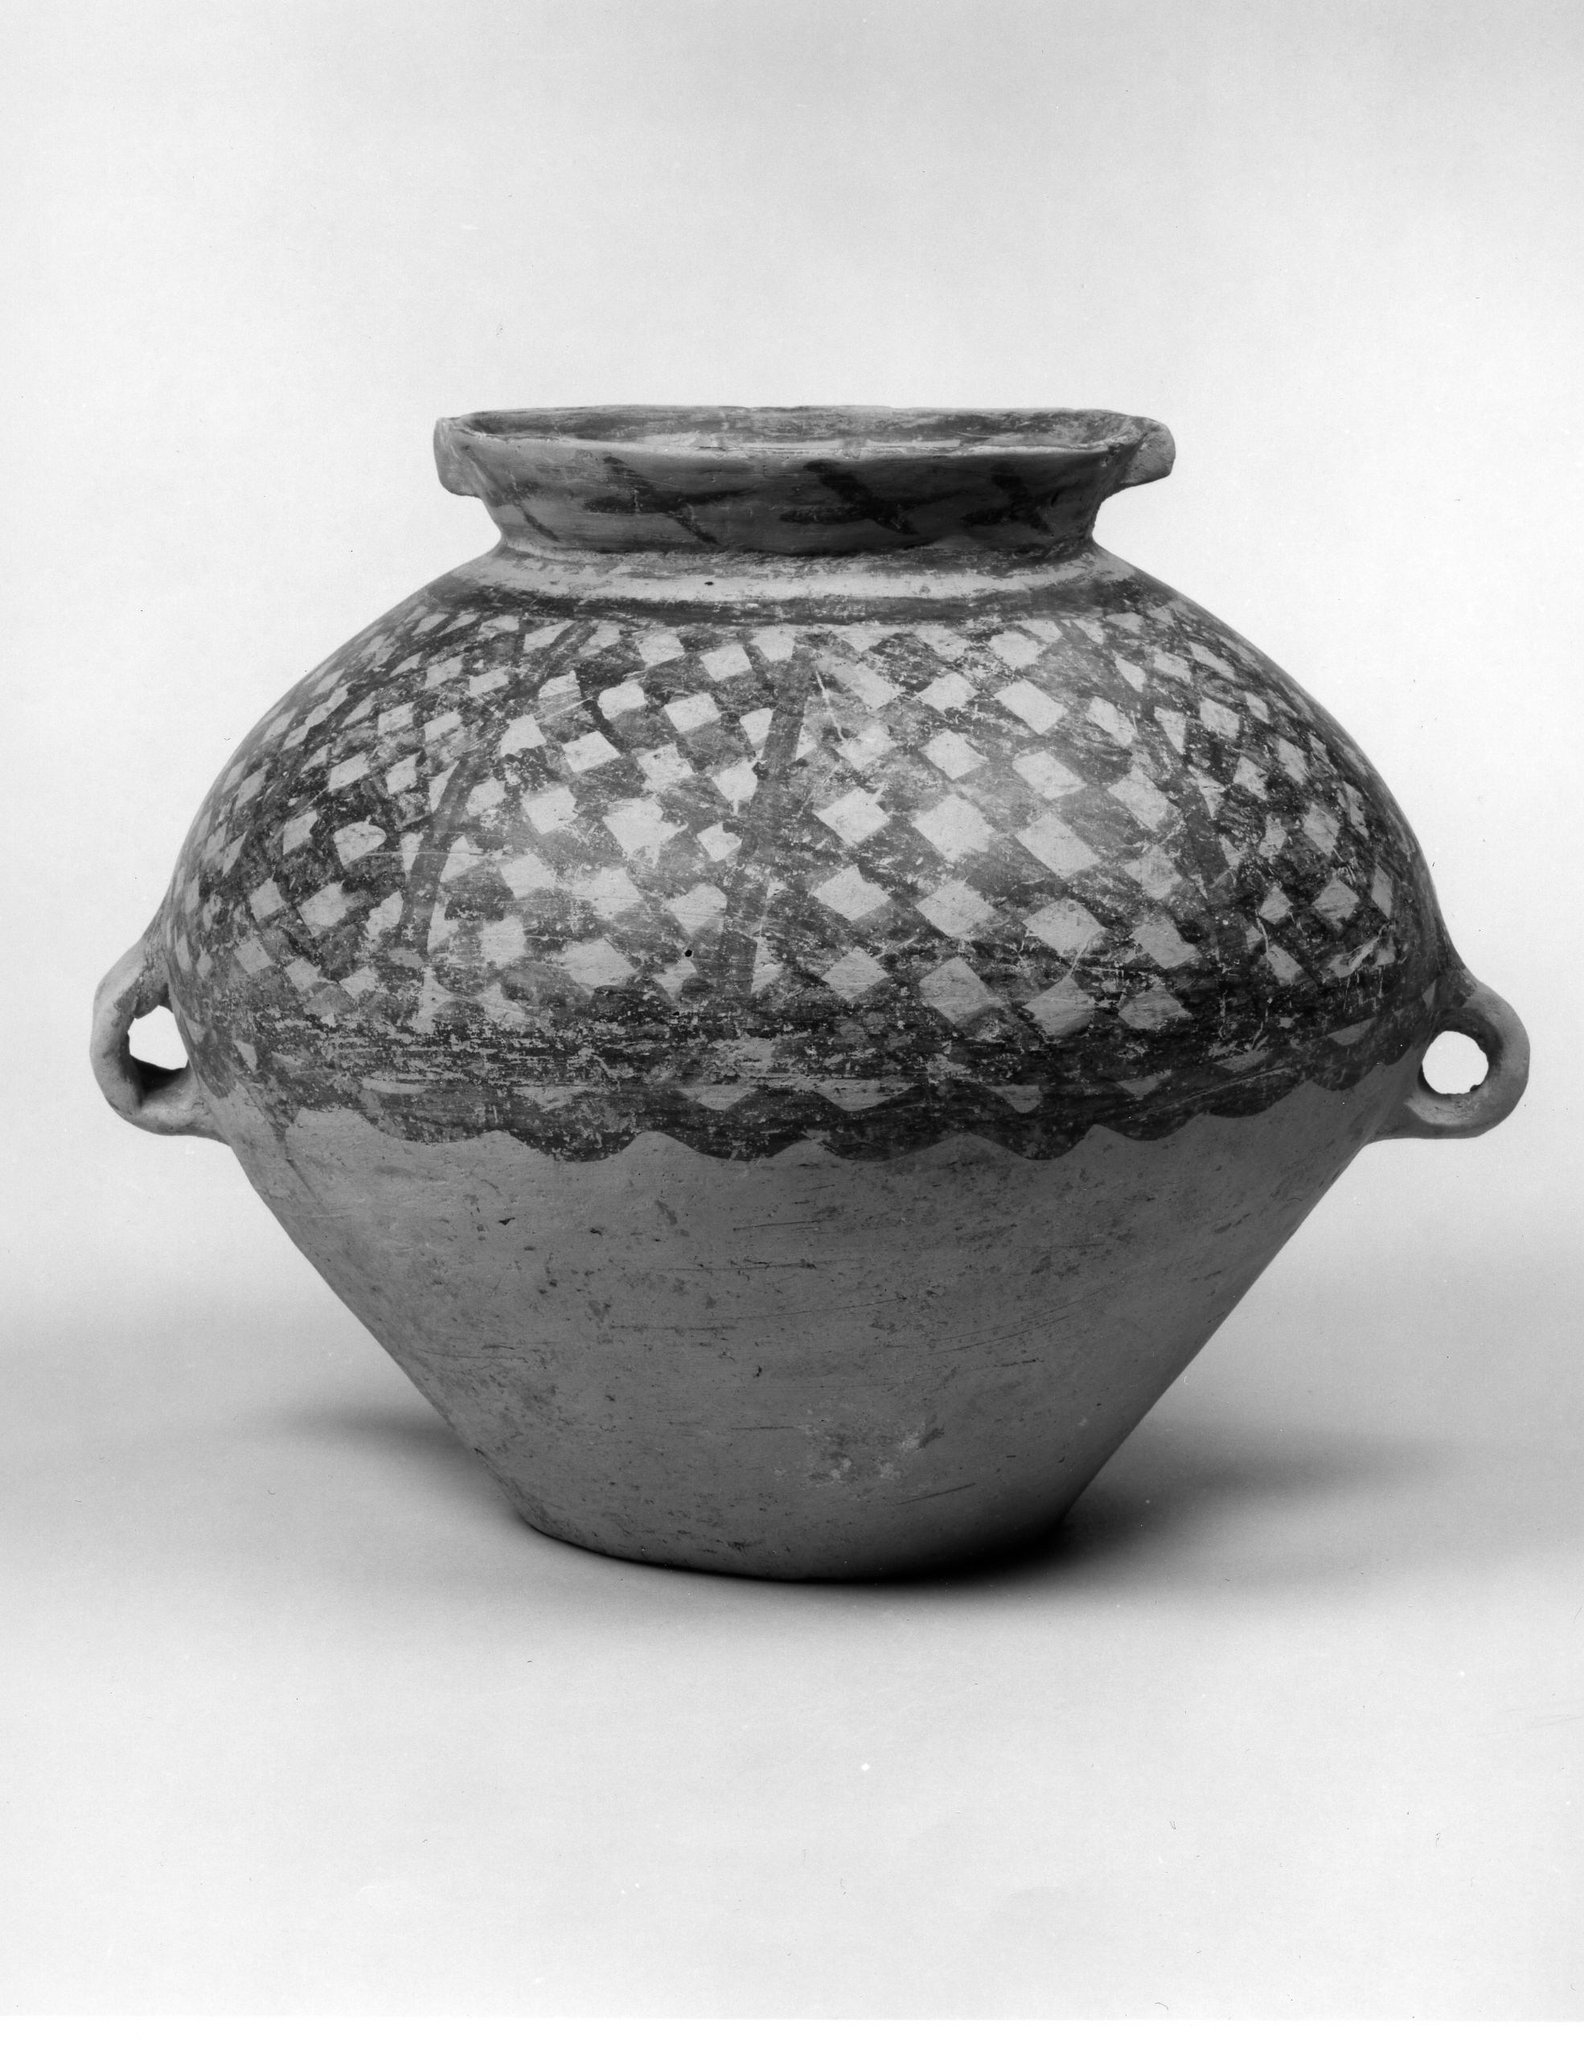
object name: jar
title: Jar (Guan)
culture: chinese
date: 2500-2300 BCE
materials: earthenware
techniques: painting